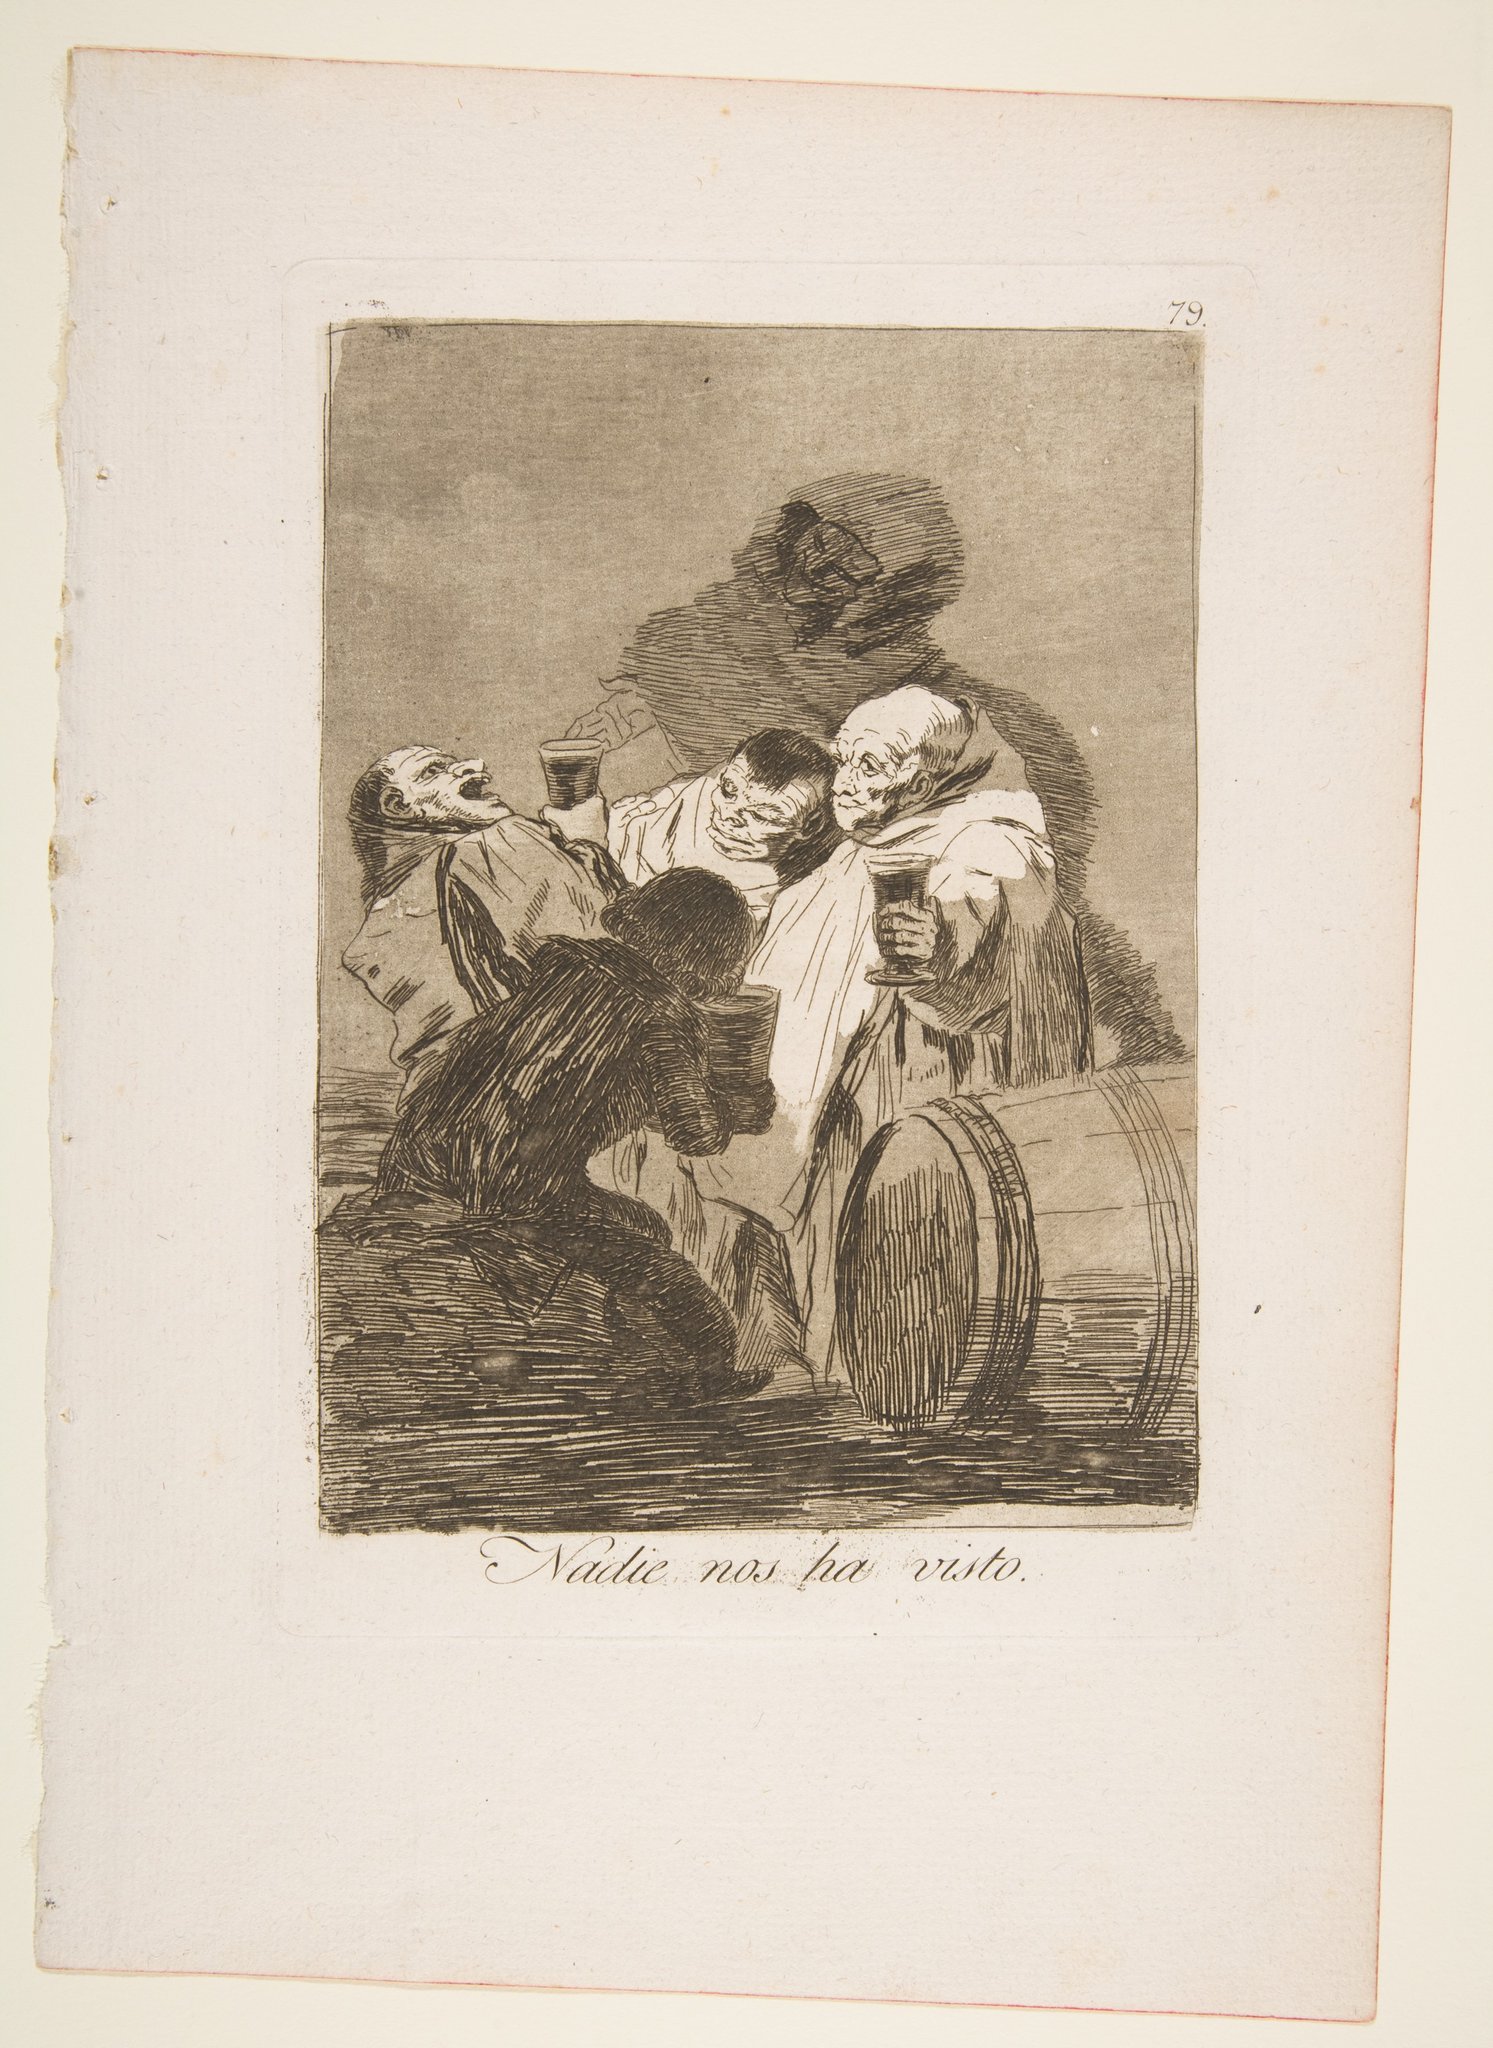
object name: print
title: Plate 79 from "Los Caprichos": No one has seen us (Nadie nos ha visto)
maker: goya (francisco de goya y lucientes)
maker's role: artist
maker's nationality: spanish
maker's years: 1746-1828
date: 1799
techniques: aquatint, engraving, burnishing, etching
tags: men,drinking